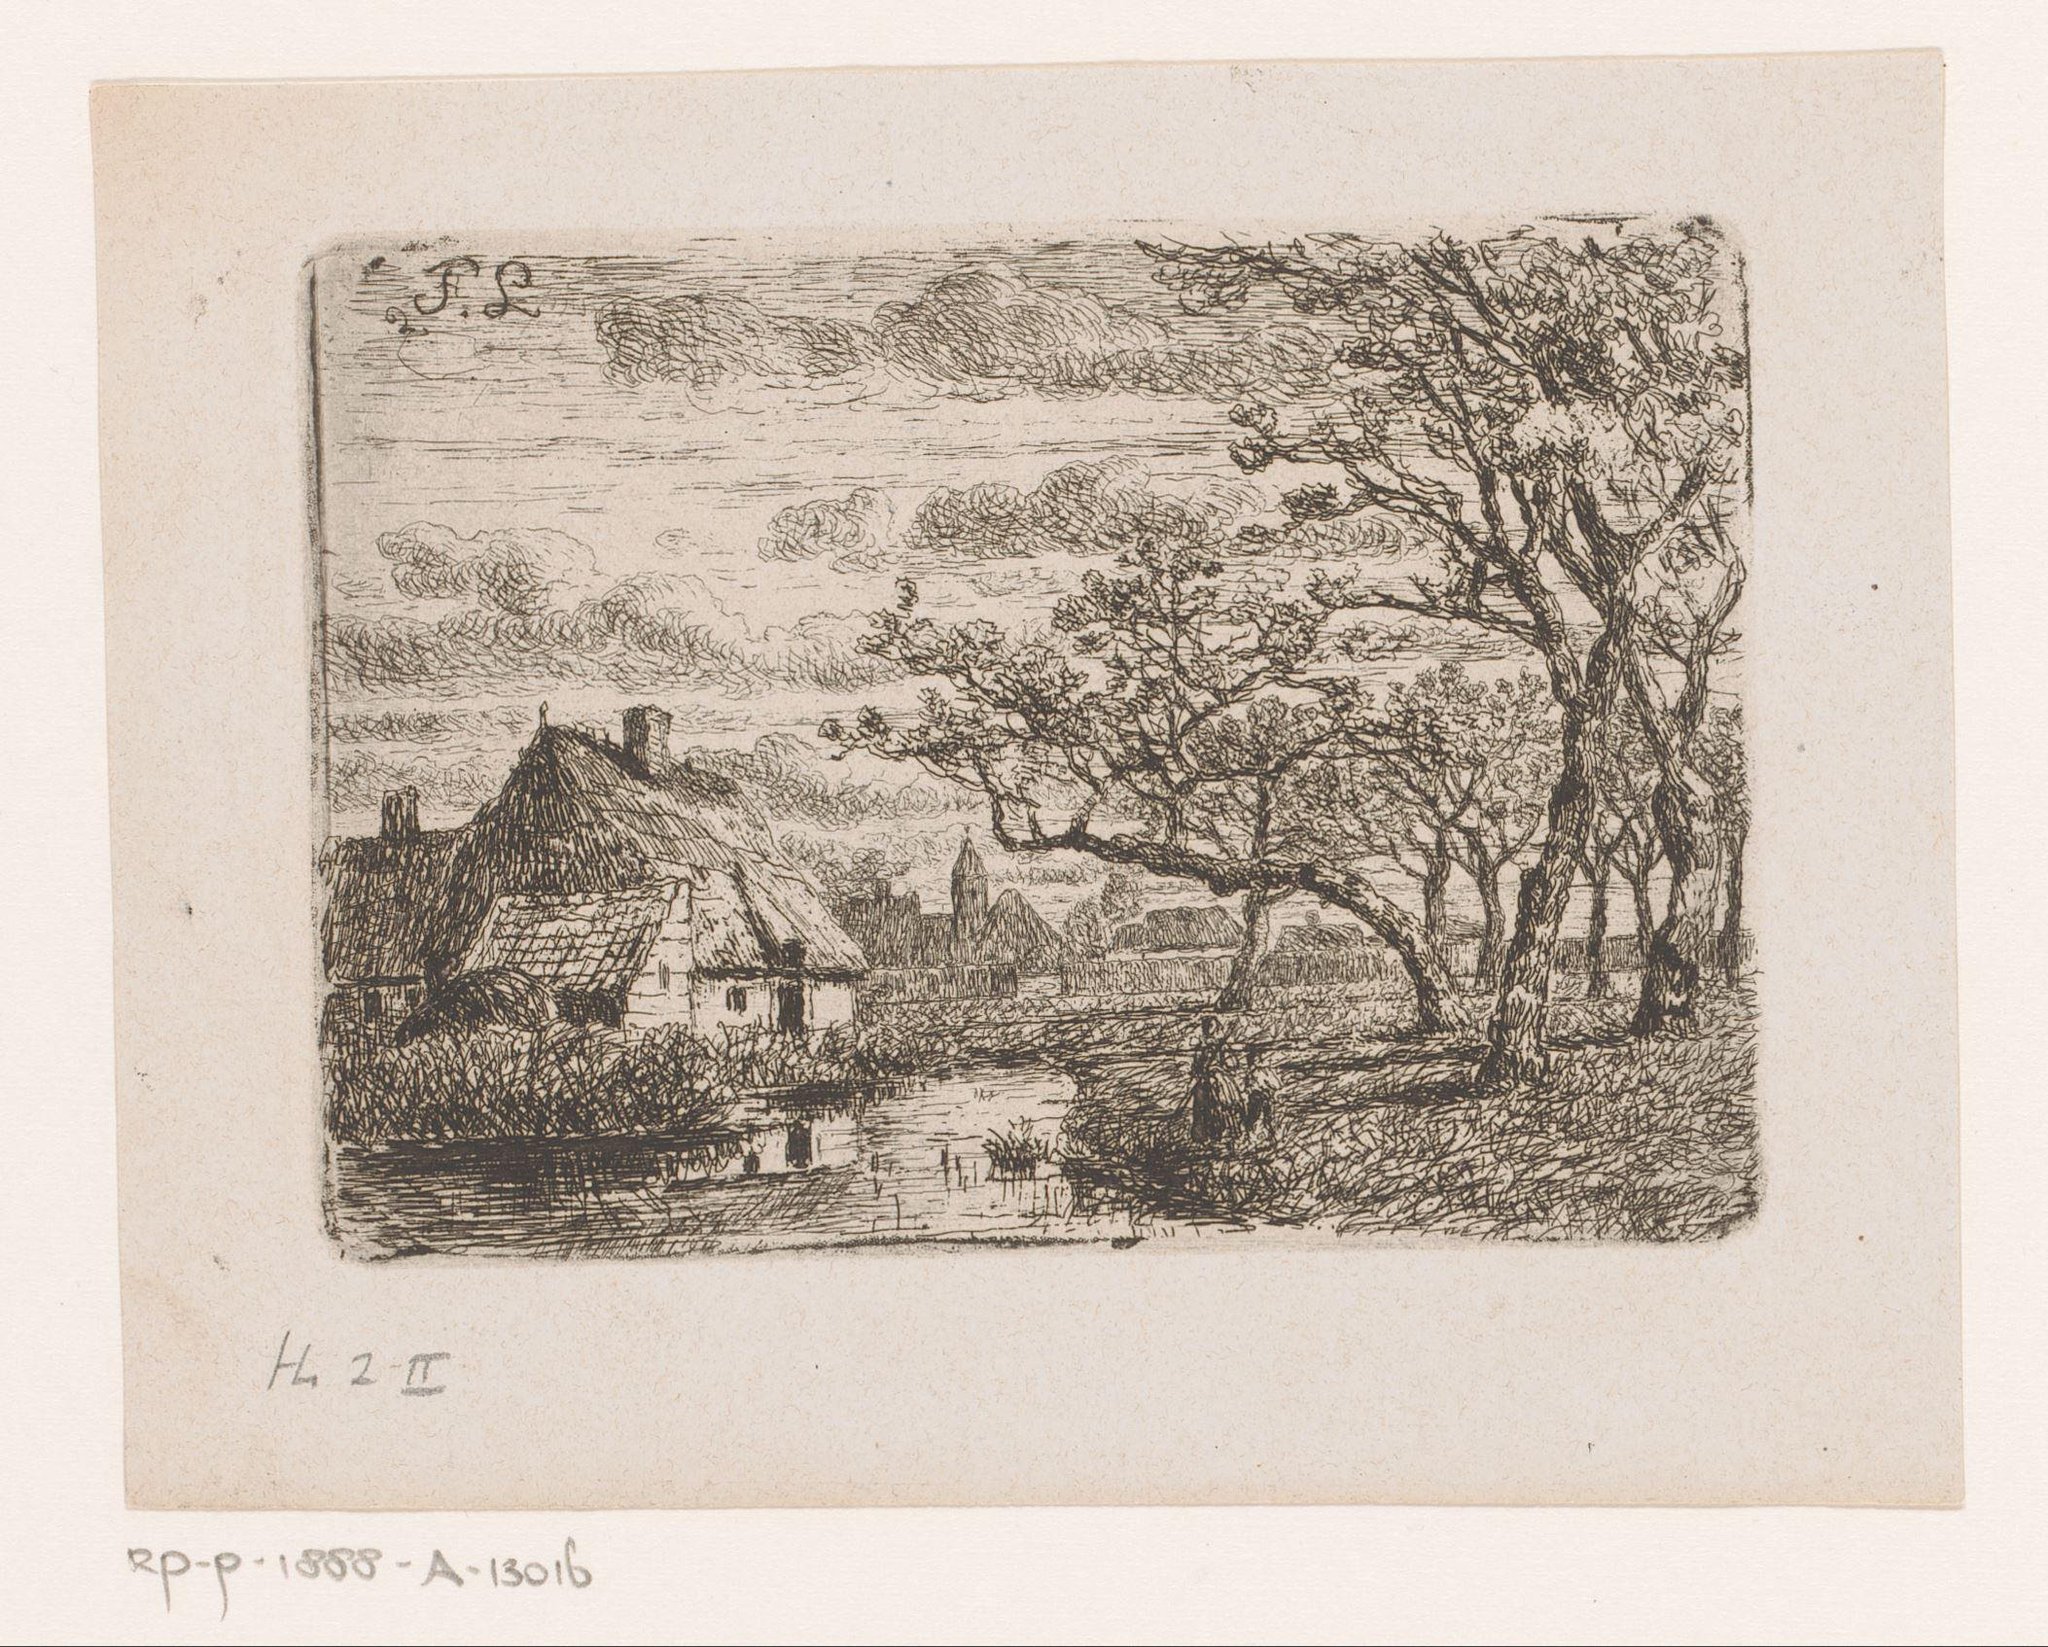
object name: print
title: Gezicht op een dorp in Oost-Vlaanderen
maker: jean pierre françois lamorinière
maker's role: print maker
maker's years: 1828-1911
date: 1838-1888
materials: paper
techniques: etching, intaglio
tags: prospect of village, silhouette of village, farm (building)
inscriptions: collector's mark: Lugt 2228